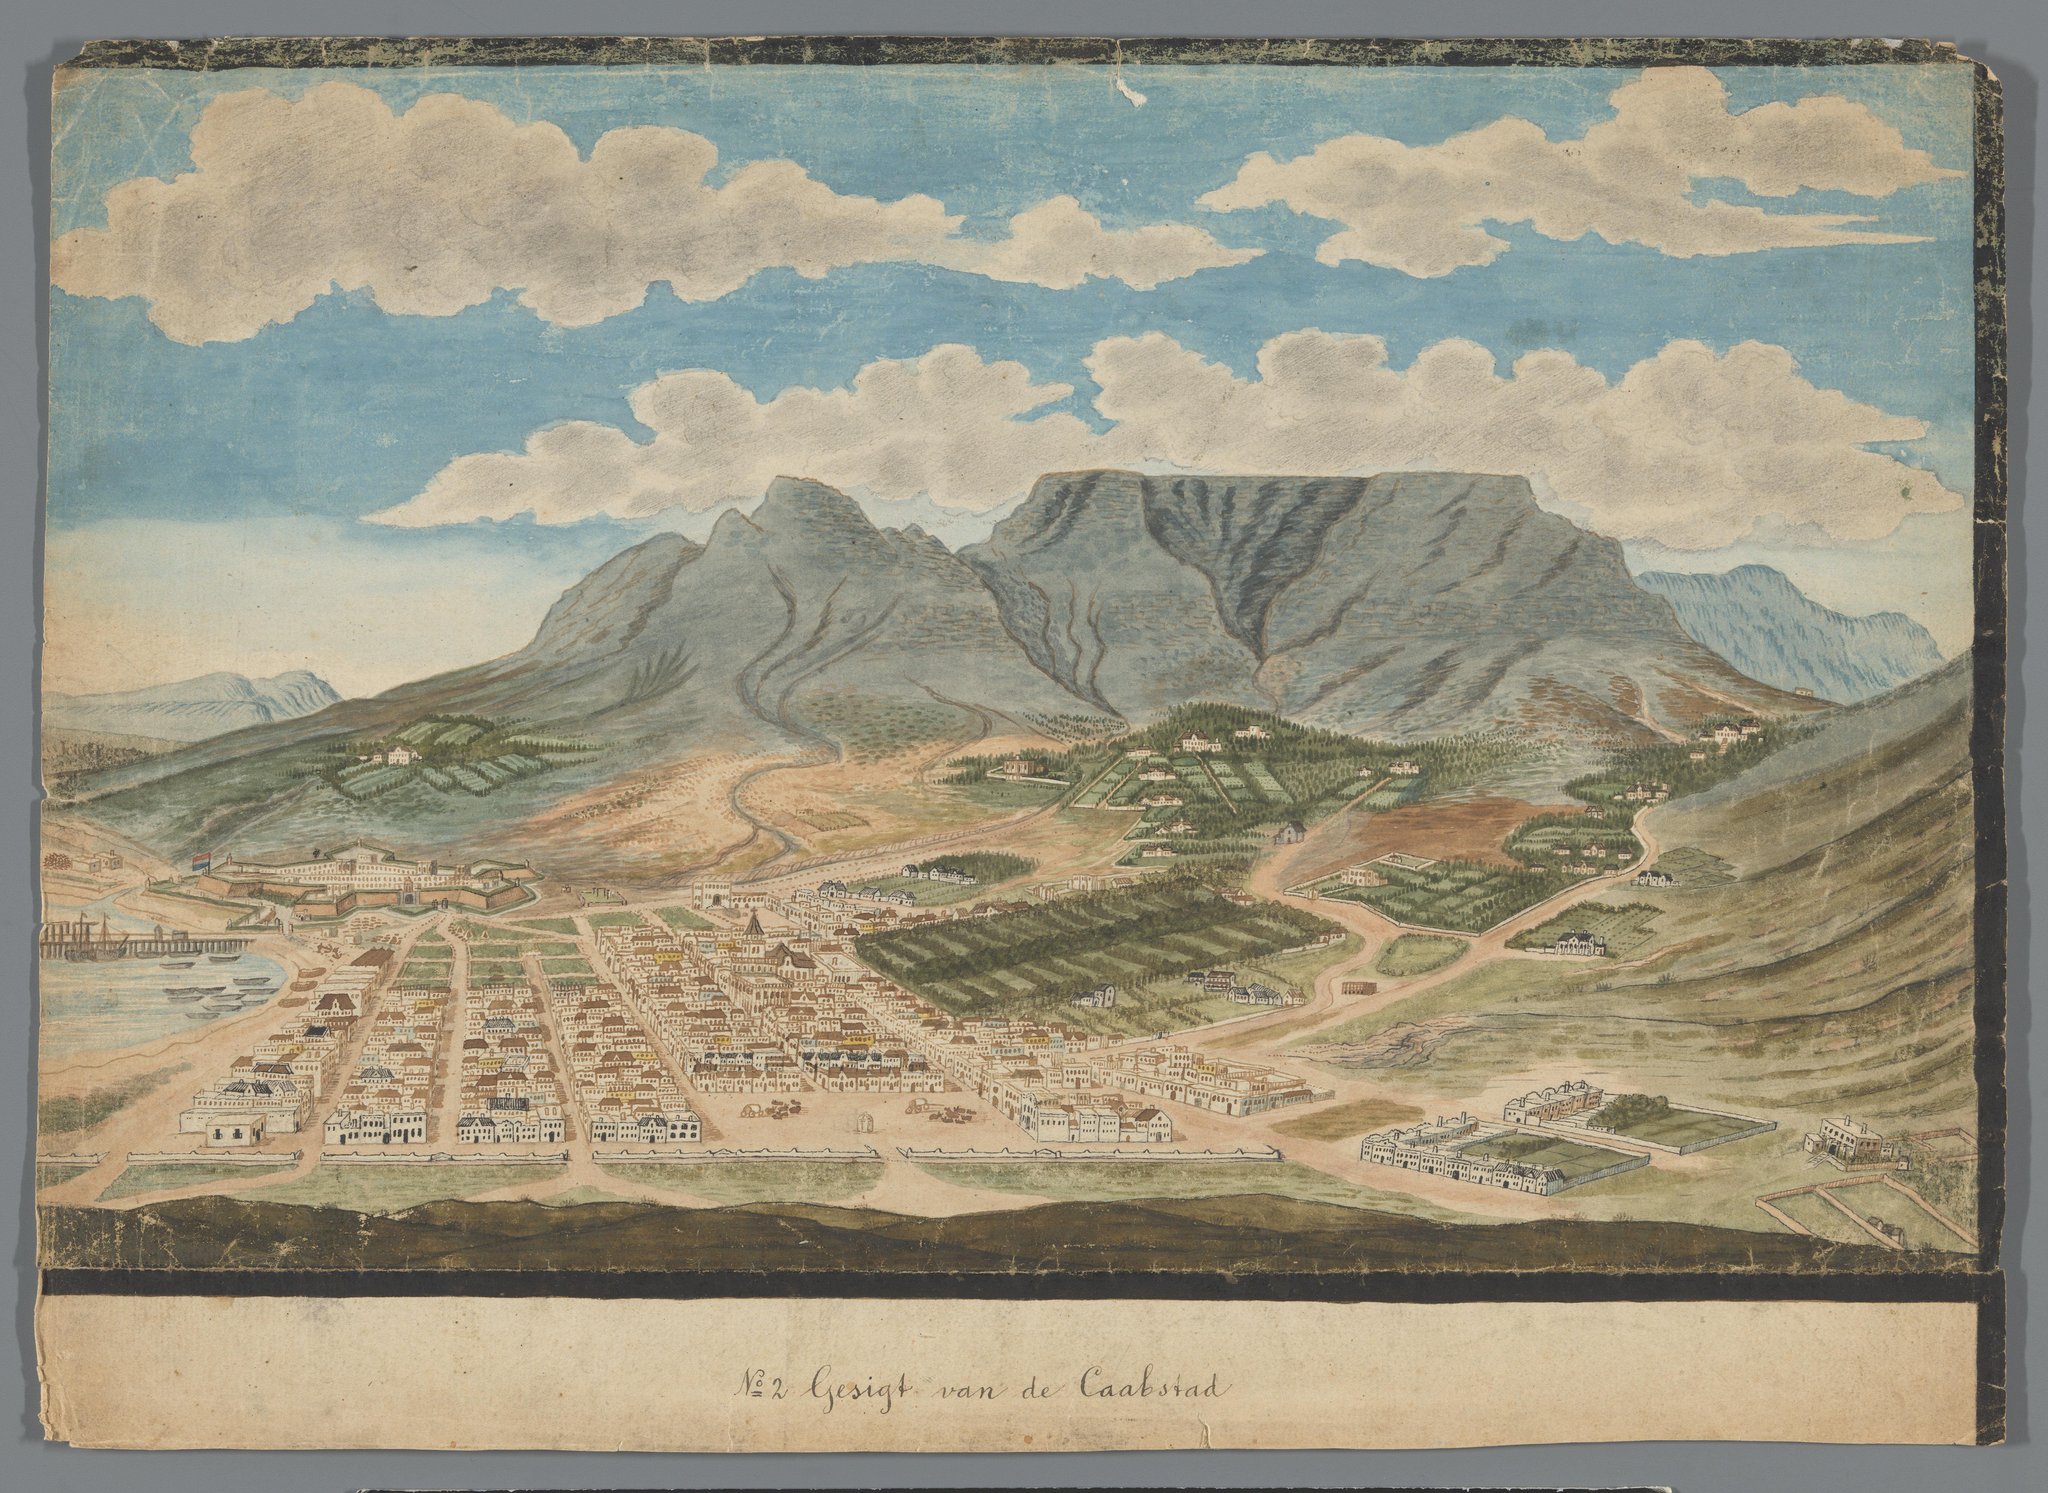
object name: drawing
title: Aquarellen betrekking hebbende op de drie reizen door de Kaap door Hendrik Swellengrebel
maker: johannes schumacher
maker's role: draughtsman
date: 1777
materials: paper, watercolor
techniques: brush, pen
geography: south africa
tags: mountain-range, snow peaks, prospect of city, town panorama, silhouette of city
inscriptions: label: ‘60’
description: Panorama van Kaapstad en omgeving, gezien naar het oosten. Op dit blad het grootste deel van de stad en Kasteel de Goede Hoop. Rechts de Compagniestuin, links de slavenloge. Op de voorgrond het Boerenplein, de uitspanplaats voor ossenwgens. Op de achtergrond de Tafelberg. Rechterhelft van een voorstelling bestaande uit twee helften.